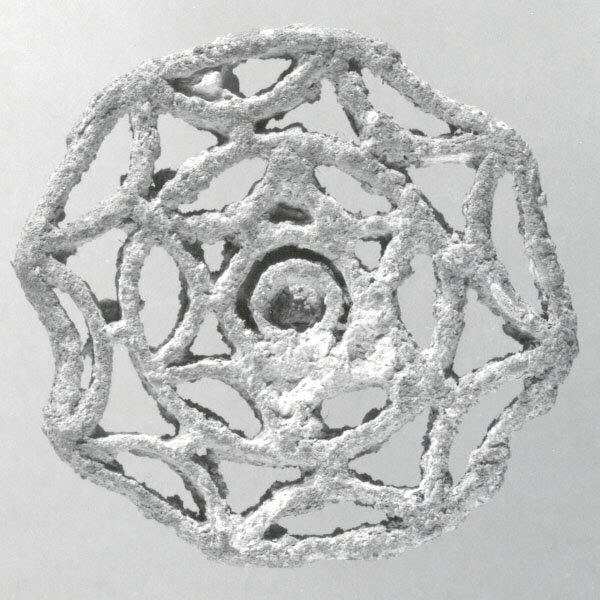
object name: stamp seal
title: Compartmented stamp seal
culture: bactria-margiana archaeological complex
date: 2333-1668 BCE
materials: copper alloy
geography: bactria-margiana